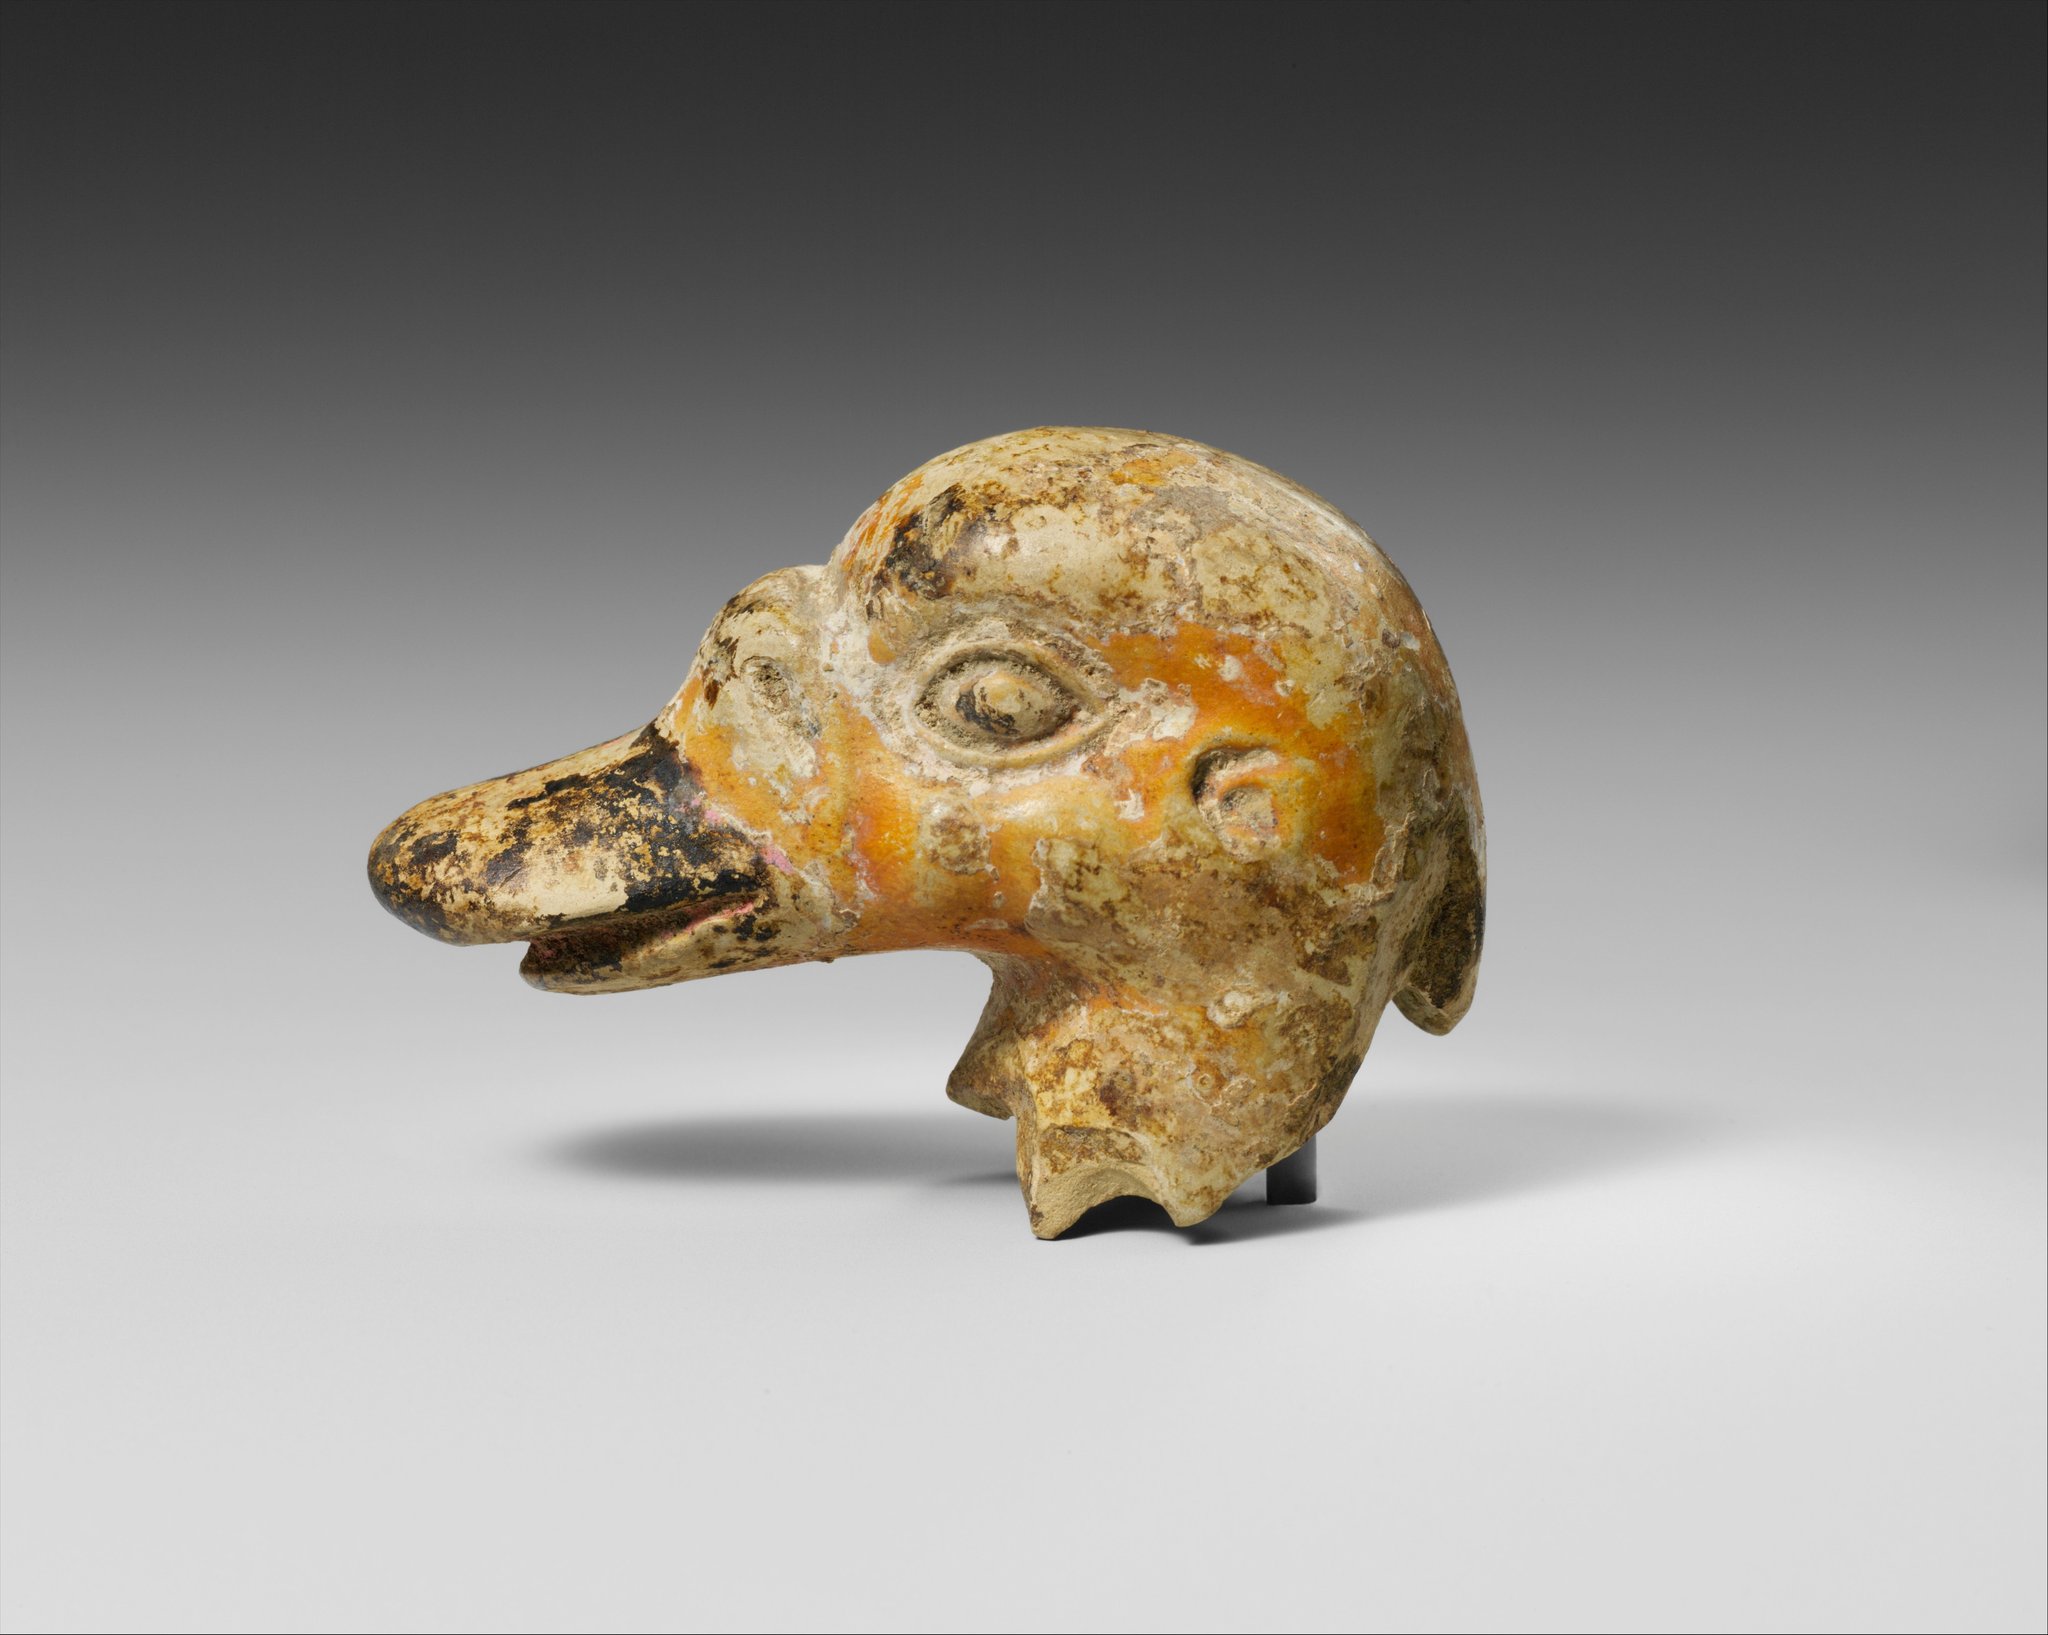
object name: fragment of a duck askos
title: Faience fragment of a duck askos (flask with spout)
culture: greek, ptolemaic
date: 200-101 BCE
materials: faience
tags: ducks